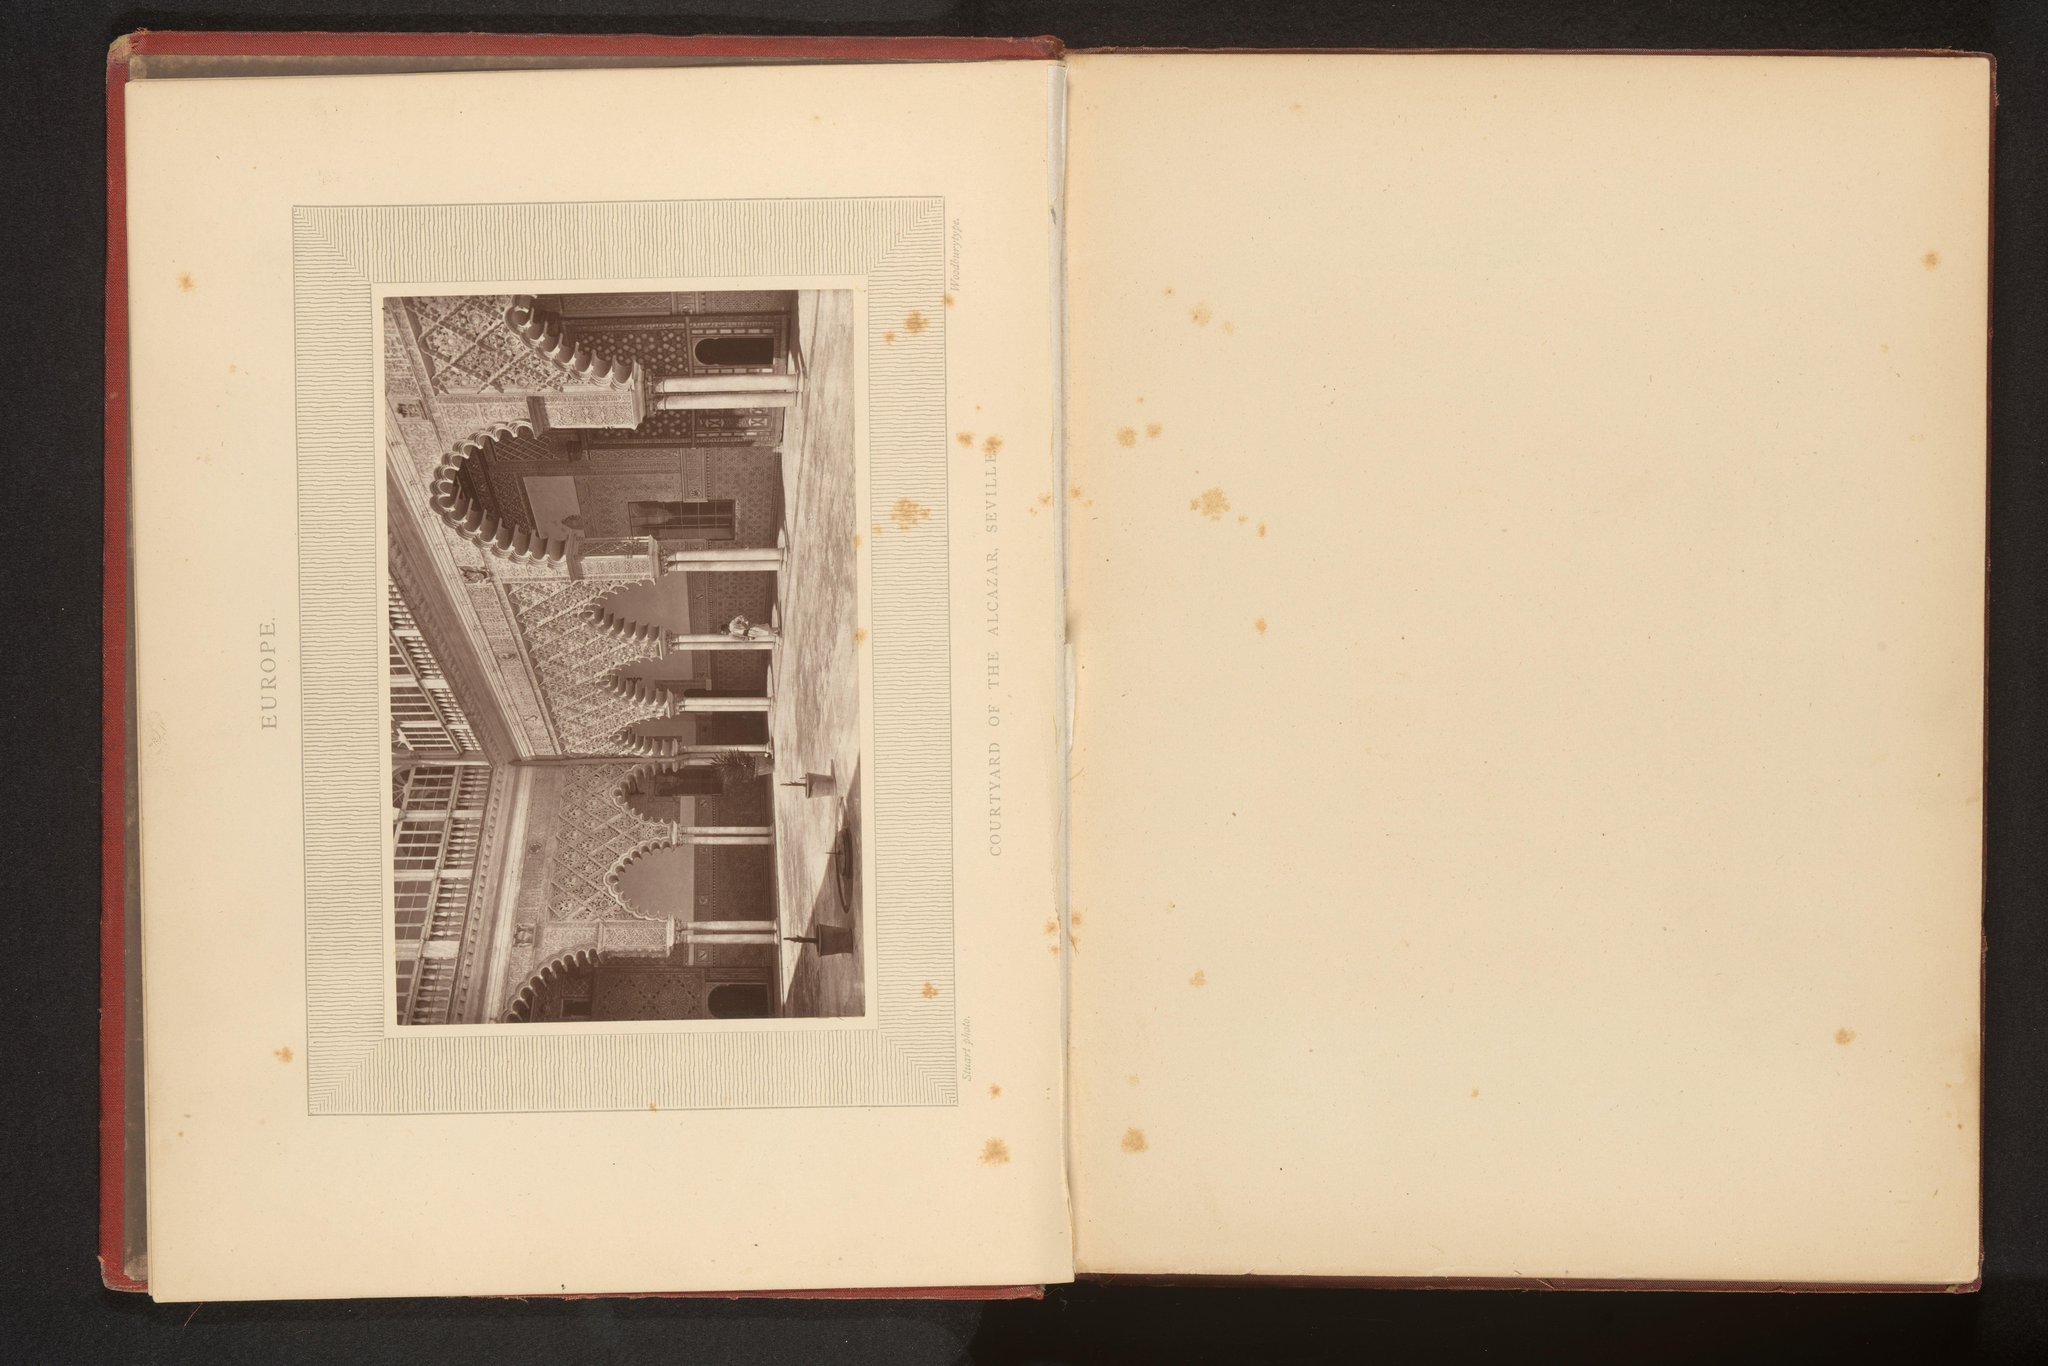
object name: photomechanical print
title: Courtyard of the Alcazar, Seville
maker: Anonymous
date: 1870-1875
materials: cardboard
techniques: woodburytype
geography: royal palace of seville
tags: palace, courtyard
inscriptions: inscription: ‘Stuart photo.’, inscription: ‘Europe’